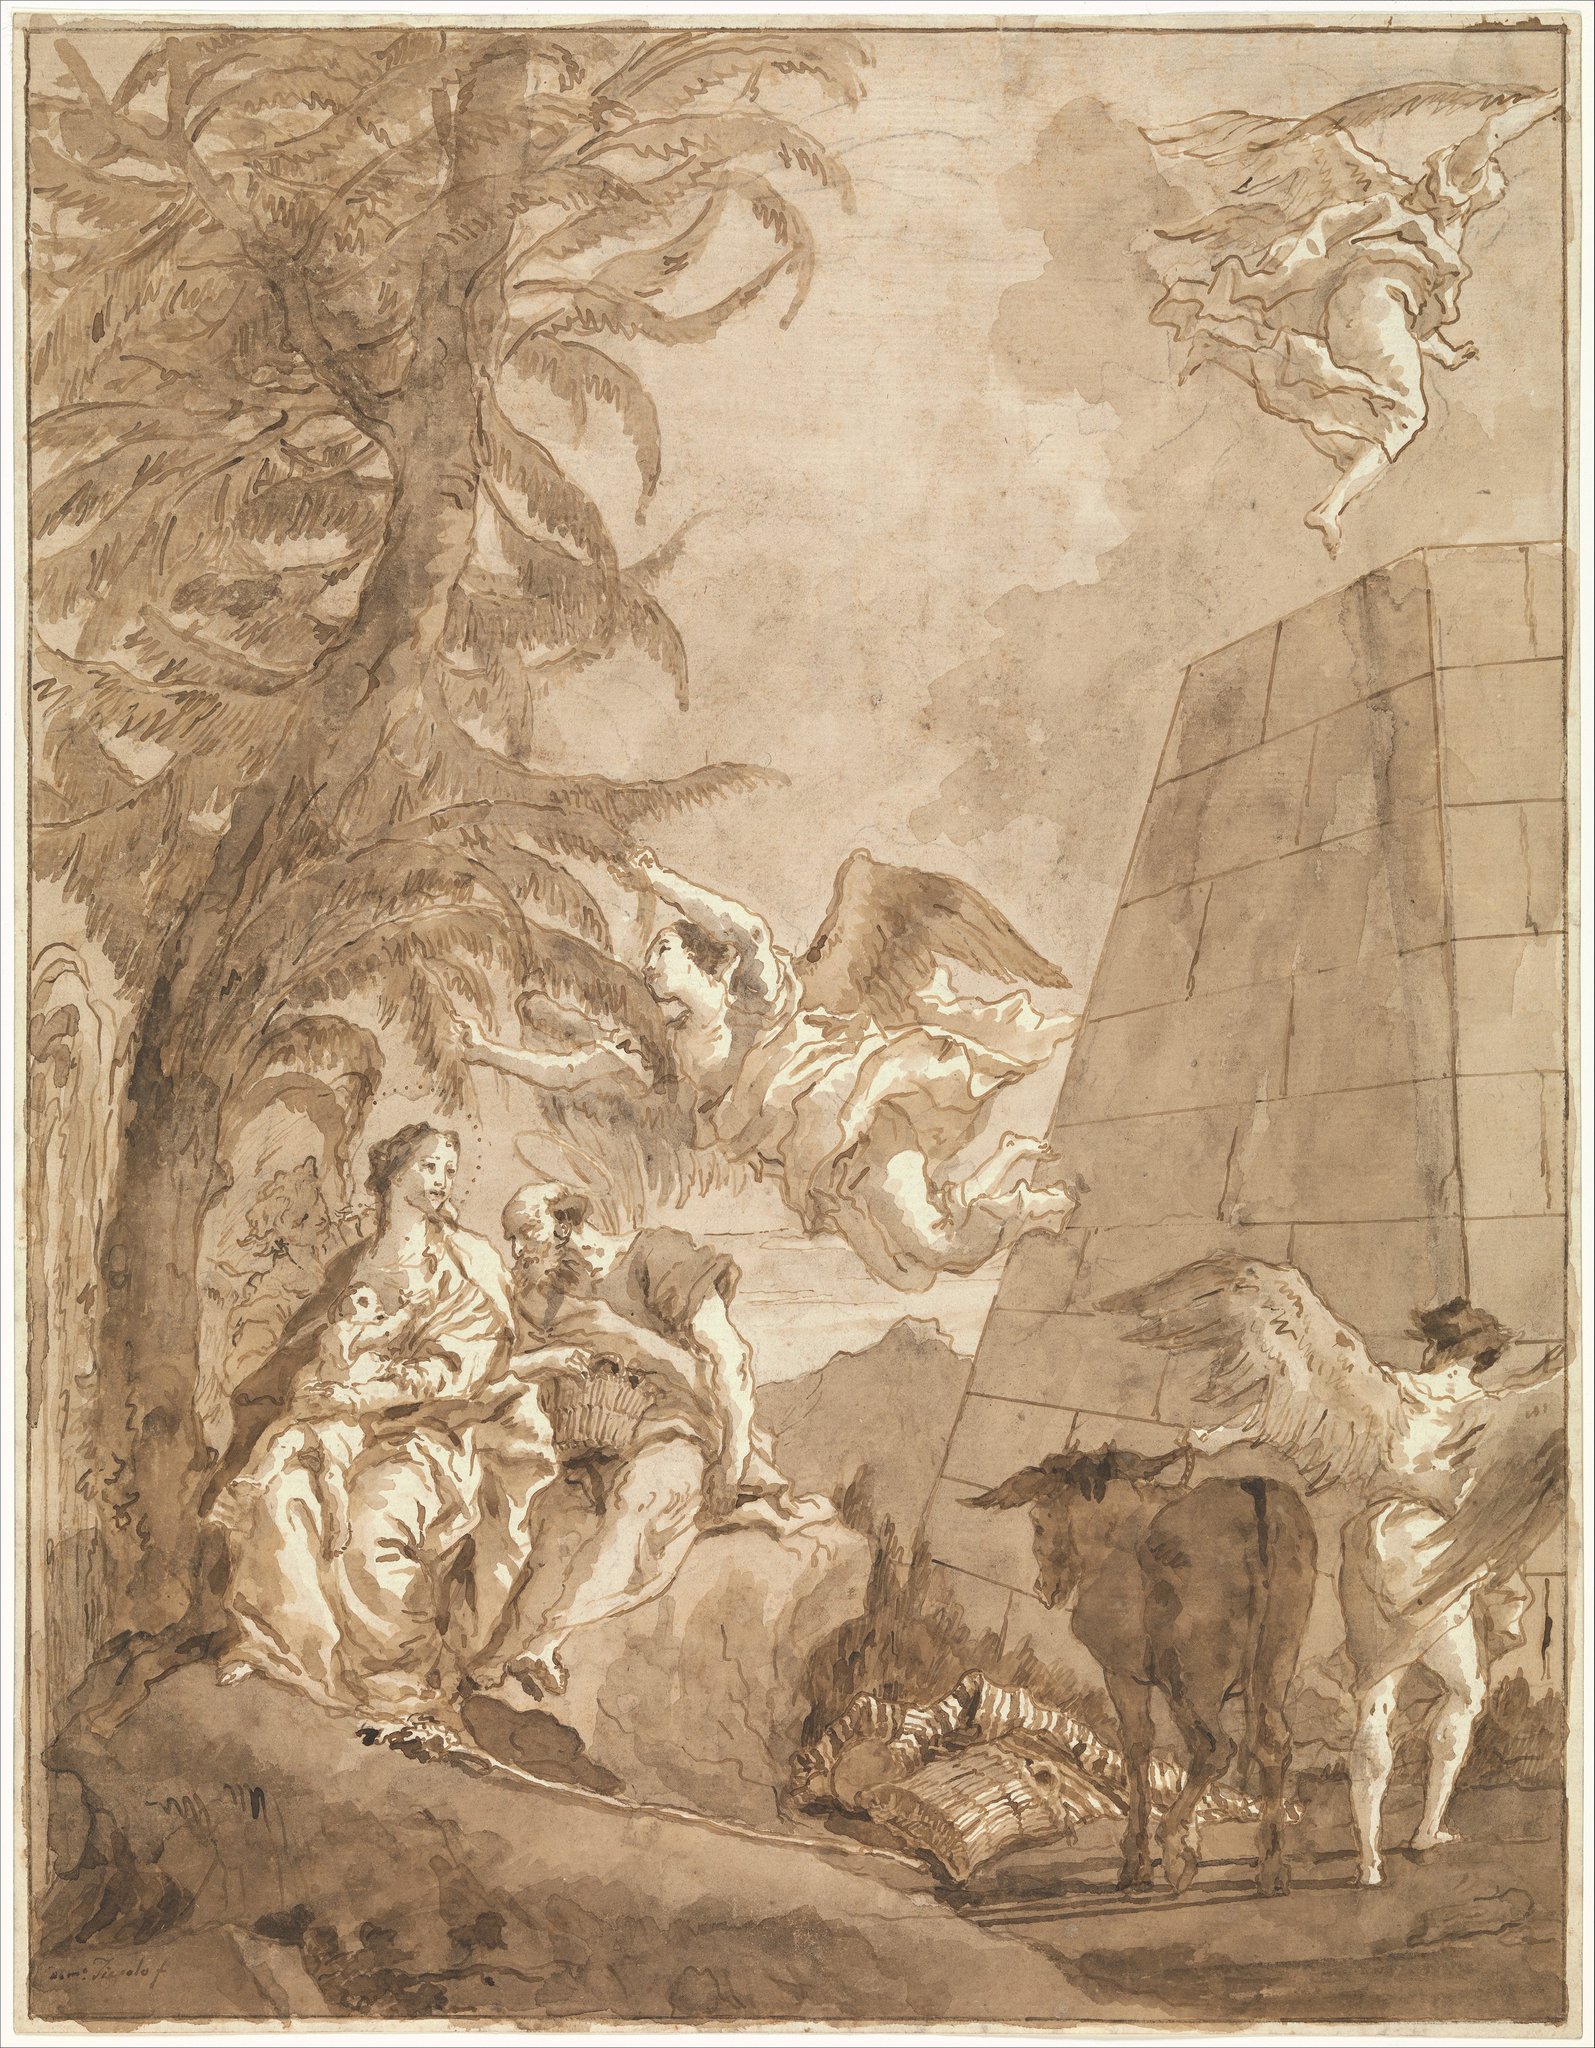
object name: drawing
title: The Rest on the Flight into Egypt (with a Truncated Pyramid on the Right)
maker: giovanni domenico tiepolo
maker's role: artist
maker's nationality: italian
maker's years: 1727-1804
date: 1770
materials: chalk, ink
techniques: pen, wash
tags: donkeys,angels,flight into egypt